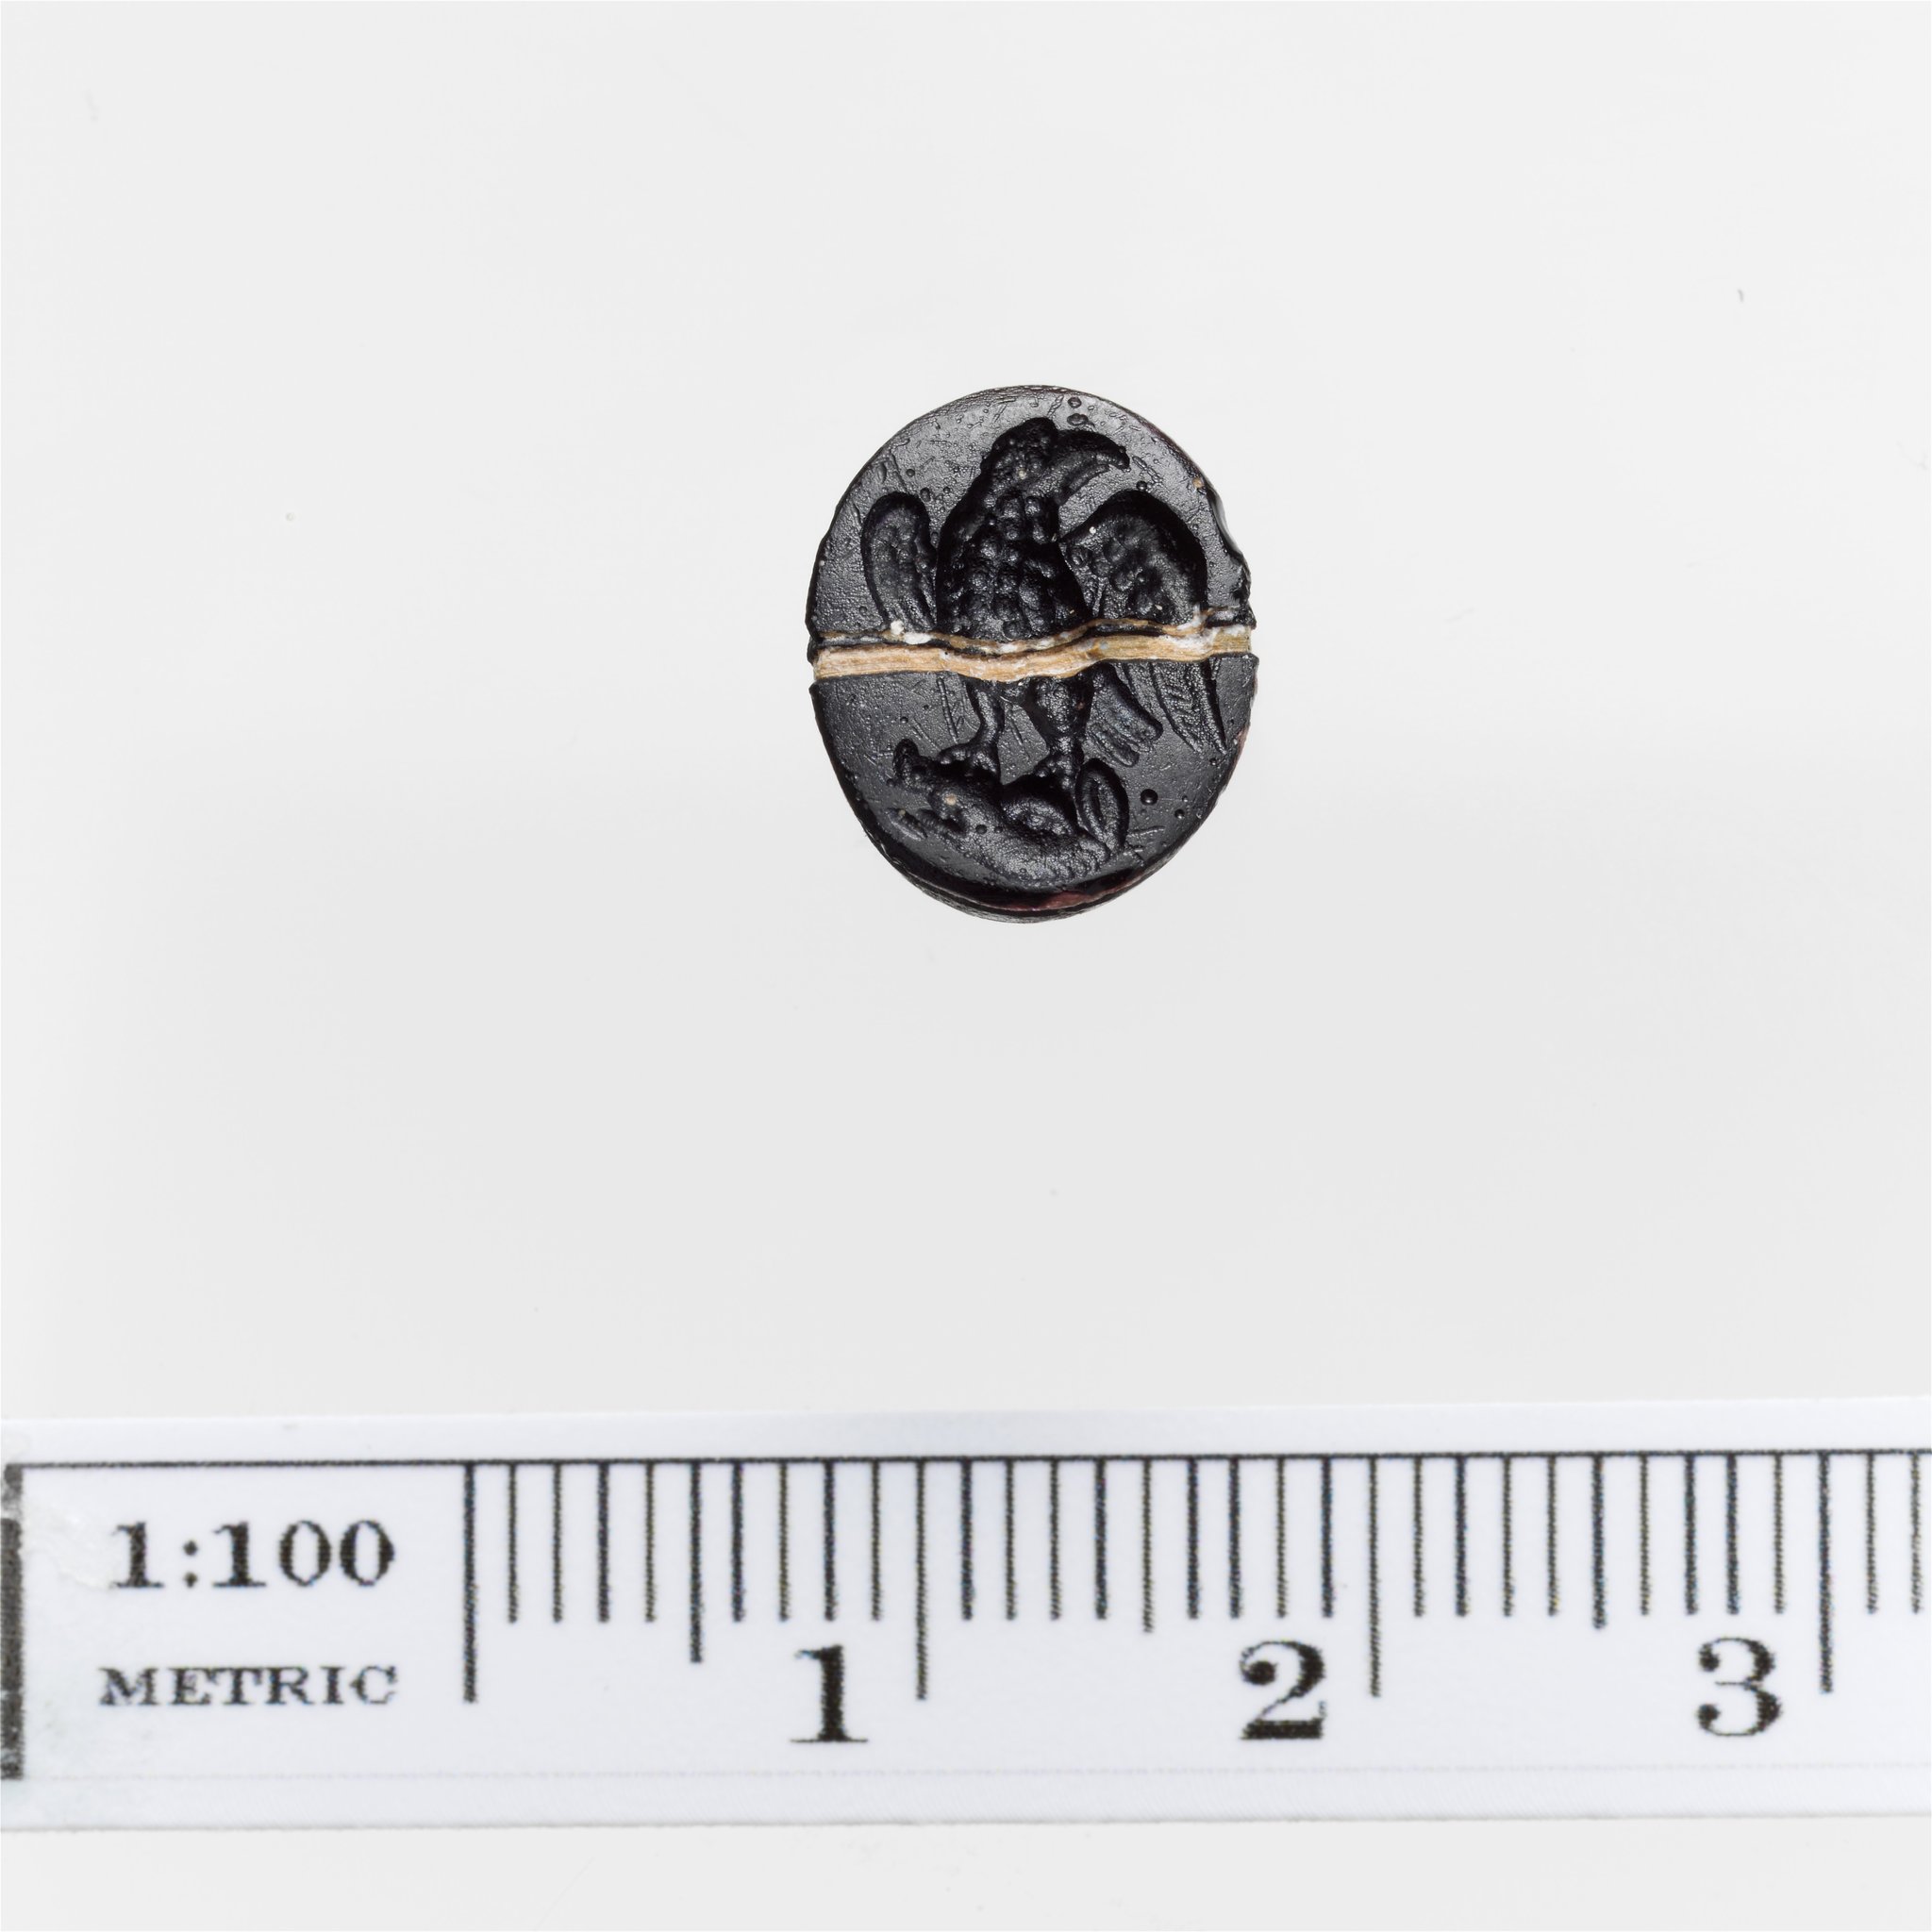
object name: intaglio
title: Opaque black glass ring stone with a white band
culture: roman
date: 1-300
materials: glass, paste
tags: eagles,boars